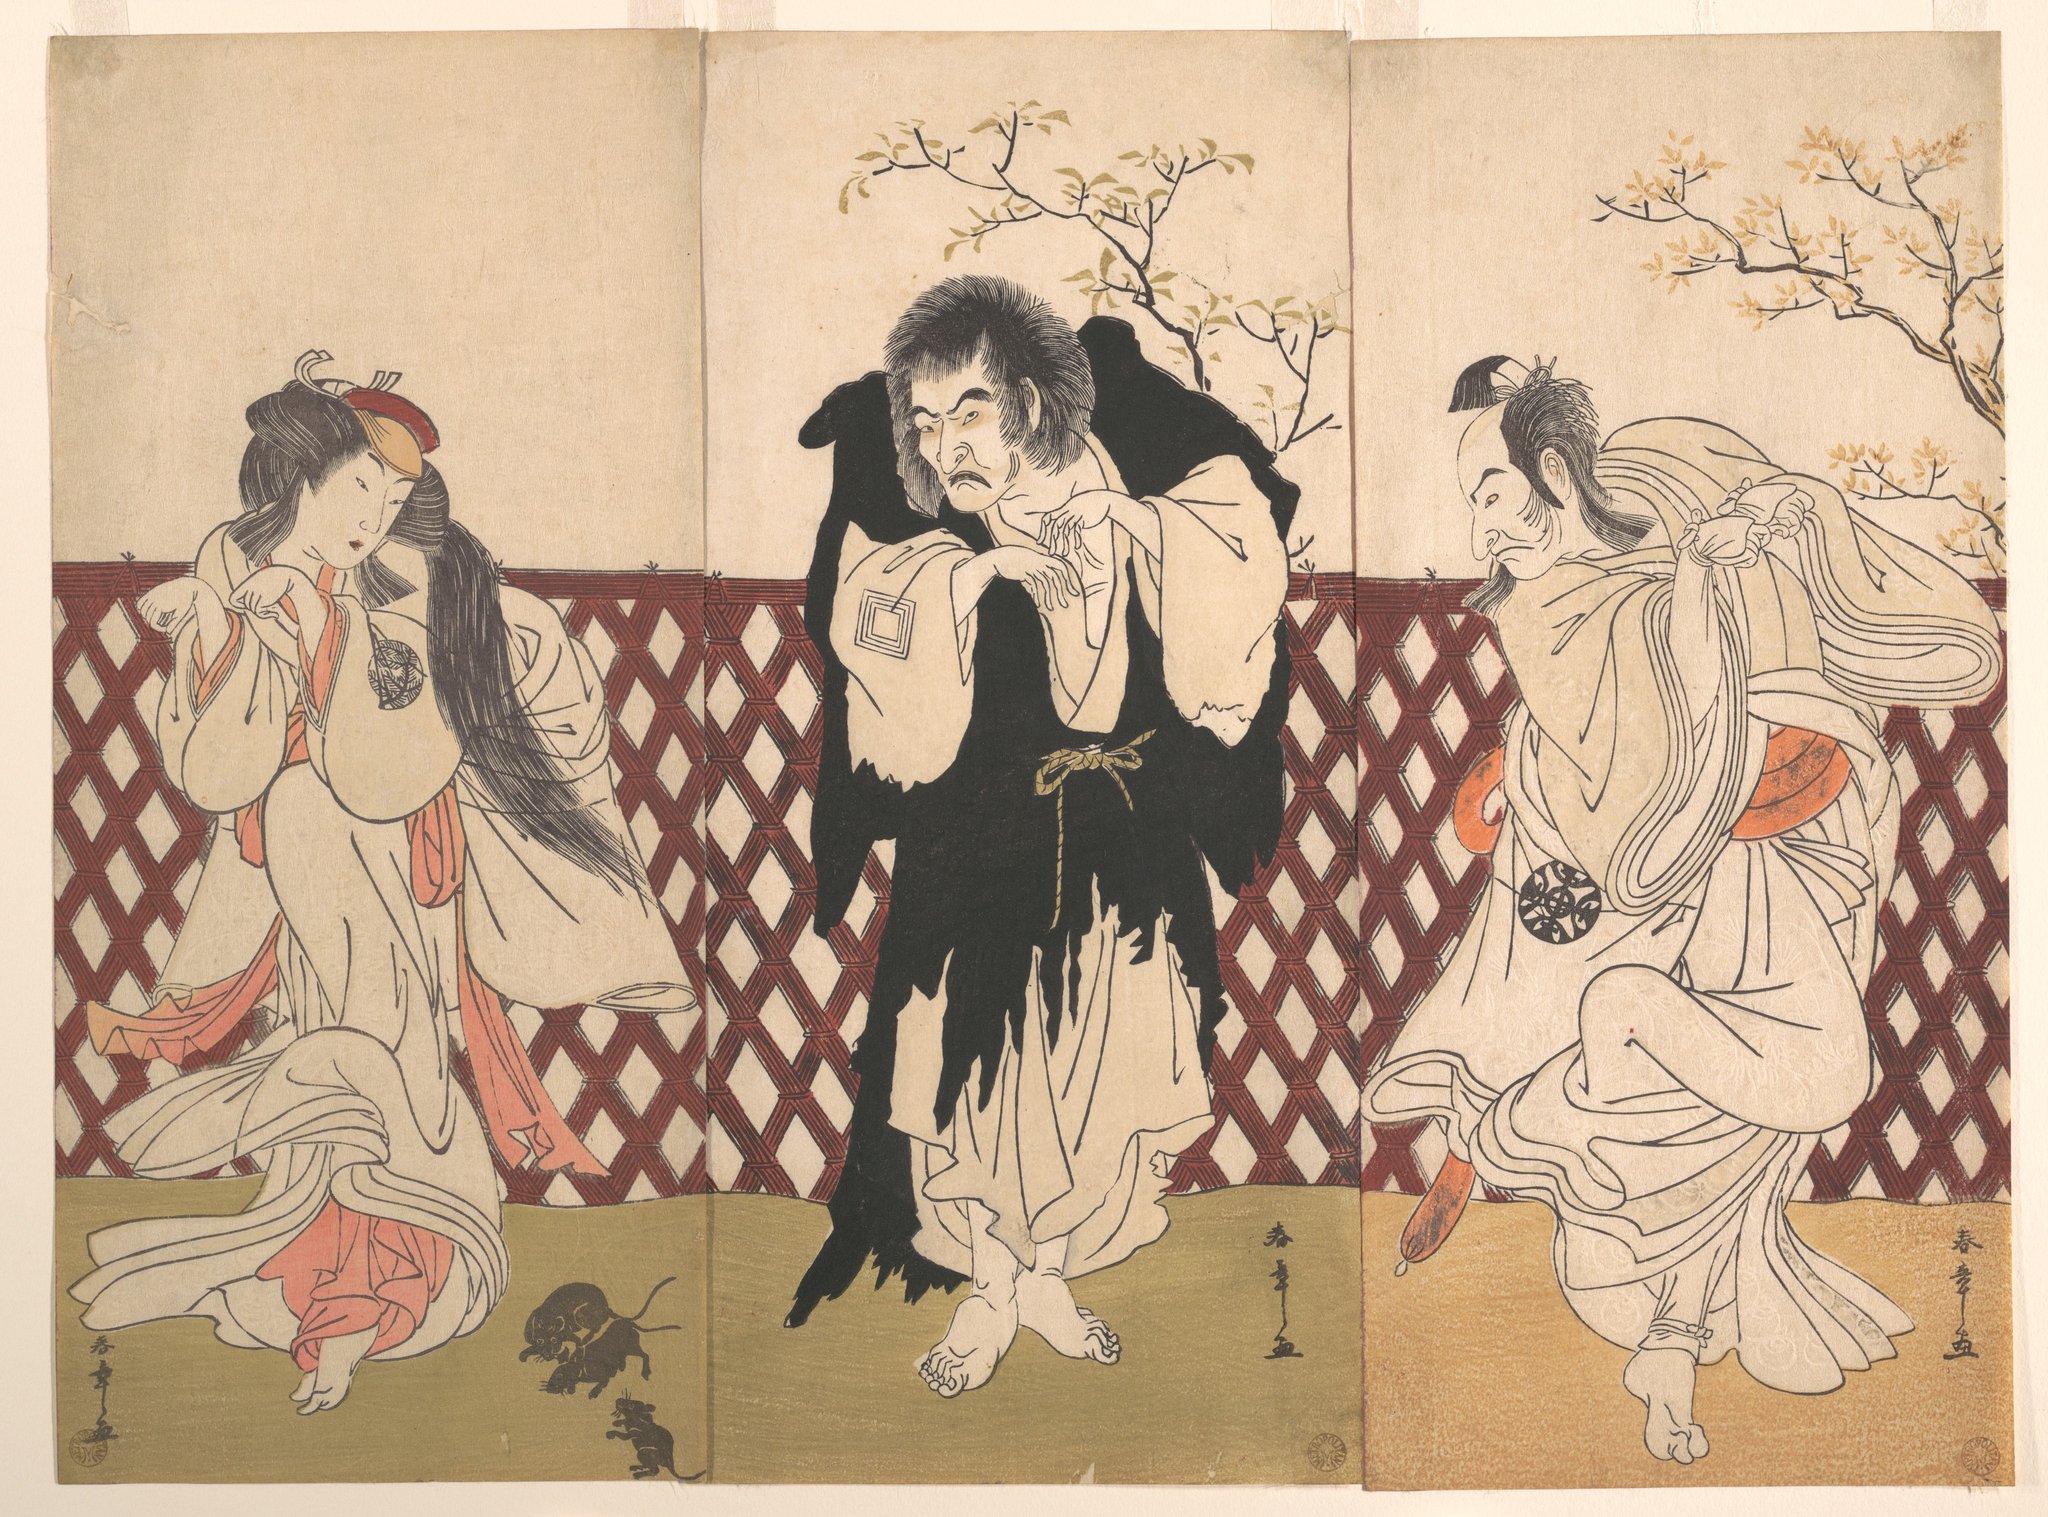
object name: woodblock print nishiki e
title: Ichikawa Danjuro IV in the Role of the Monk Mongaku from the Play Hana-zumo Genji-biki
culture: japanese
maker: katsukawa shunshō 勝川春章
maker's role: artist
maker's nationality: japanese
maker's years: 1726-1792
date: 1775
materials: ink, paper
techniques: nishiki e, woodblock print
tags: men,women,mice,actors